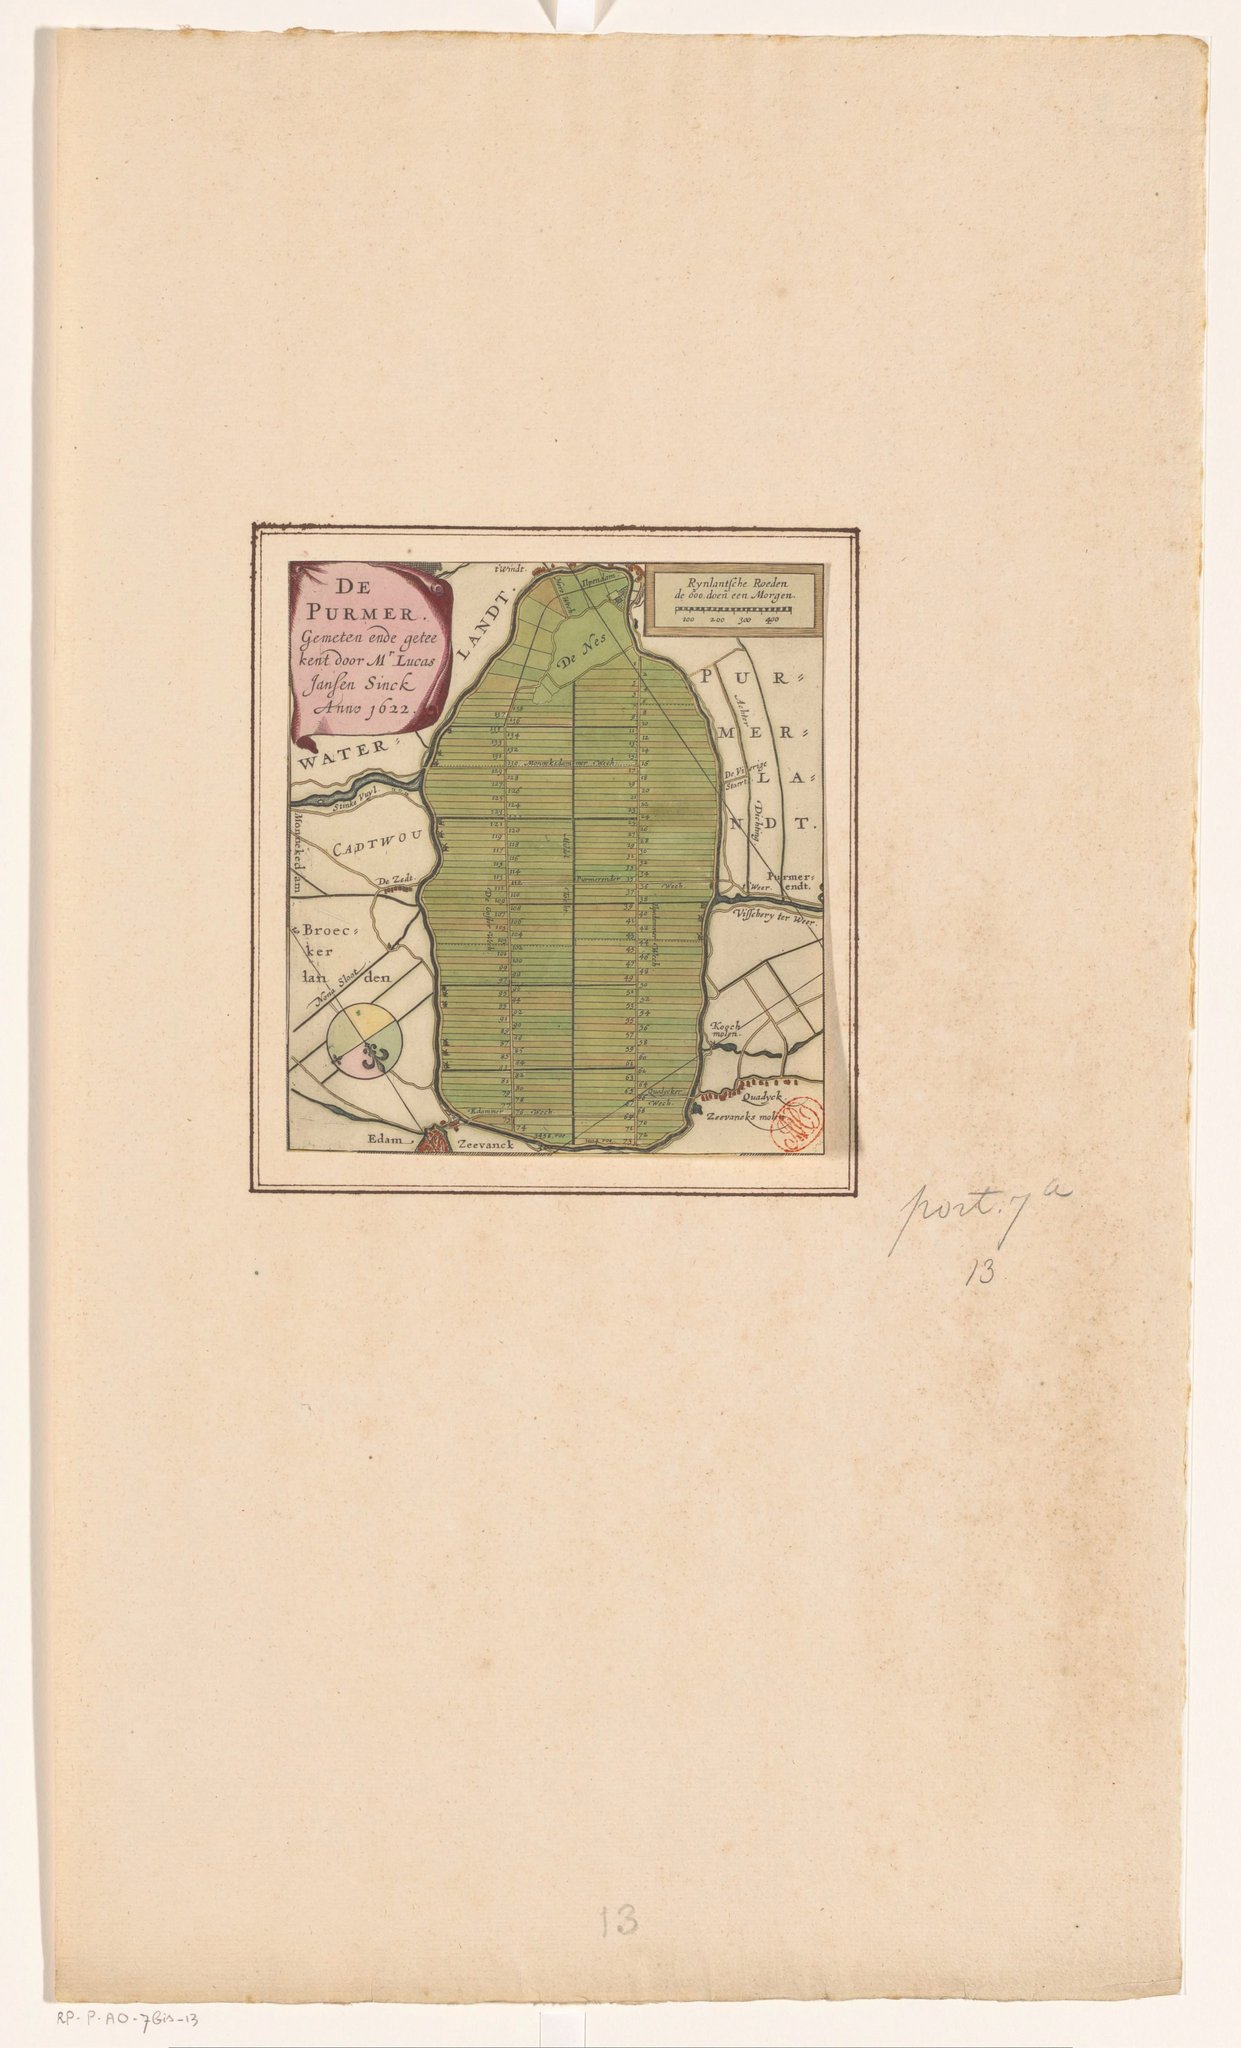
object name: print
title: Kaart van de Purmer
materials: paper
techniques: engraving, hand coloring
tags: maps of separate countries or regions, polder, reclaimed land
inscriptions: collector's mark: Lugt 195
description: Linksboven de titel, rechtsboven een schaalstok: Rynlantsche roeden de 600 doen een morgen.